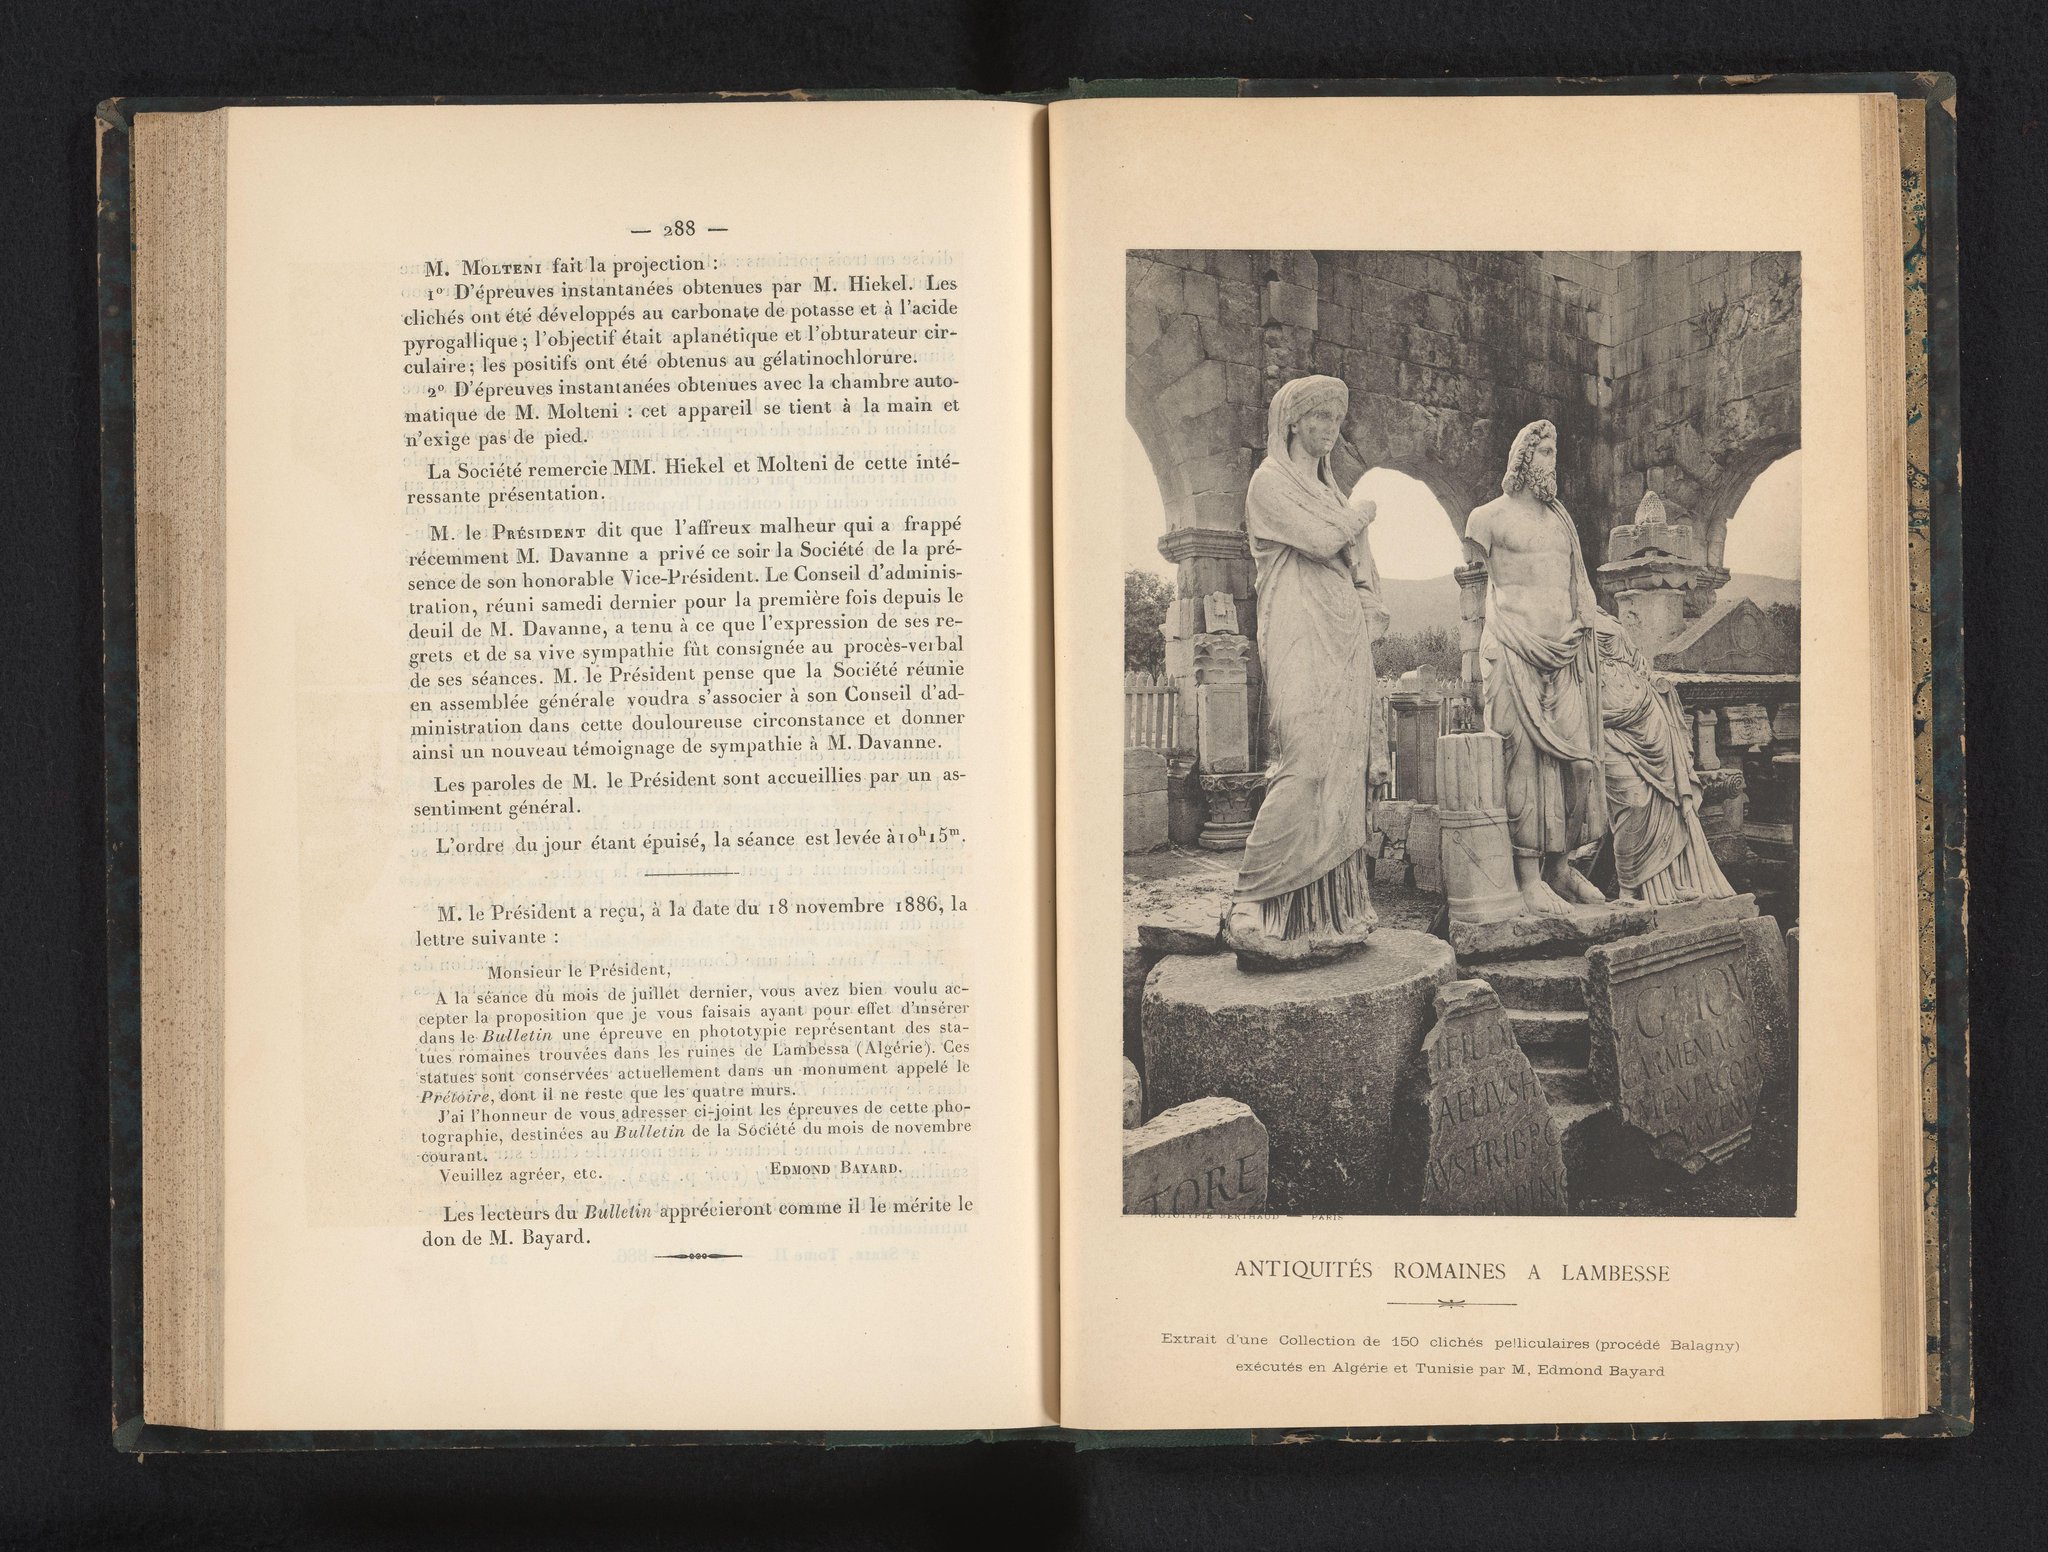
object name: page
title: Romeinse oudheden te Lambaesis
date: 1881-1886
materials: paper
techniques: photograph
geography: lambaesis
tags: inscription, statues, paintings, etc. ~ objects of worship in roman religion, piece of sculpture, reproduction of a piece of sculpture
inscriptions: inscription: ‘Phototypie Berthaud - Paris/ Extrait d'une Collection de 150 clichés pelliculaires (procédé Balagny)/ exécutes en Algérie et Tunisie par M, Edmond Bayard’